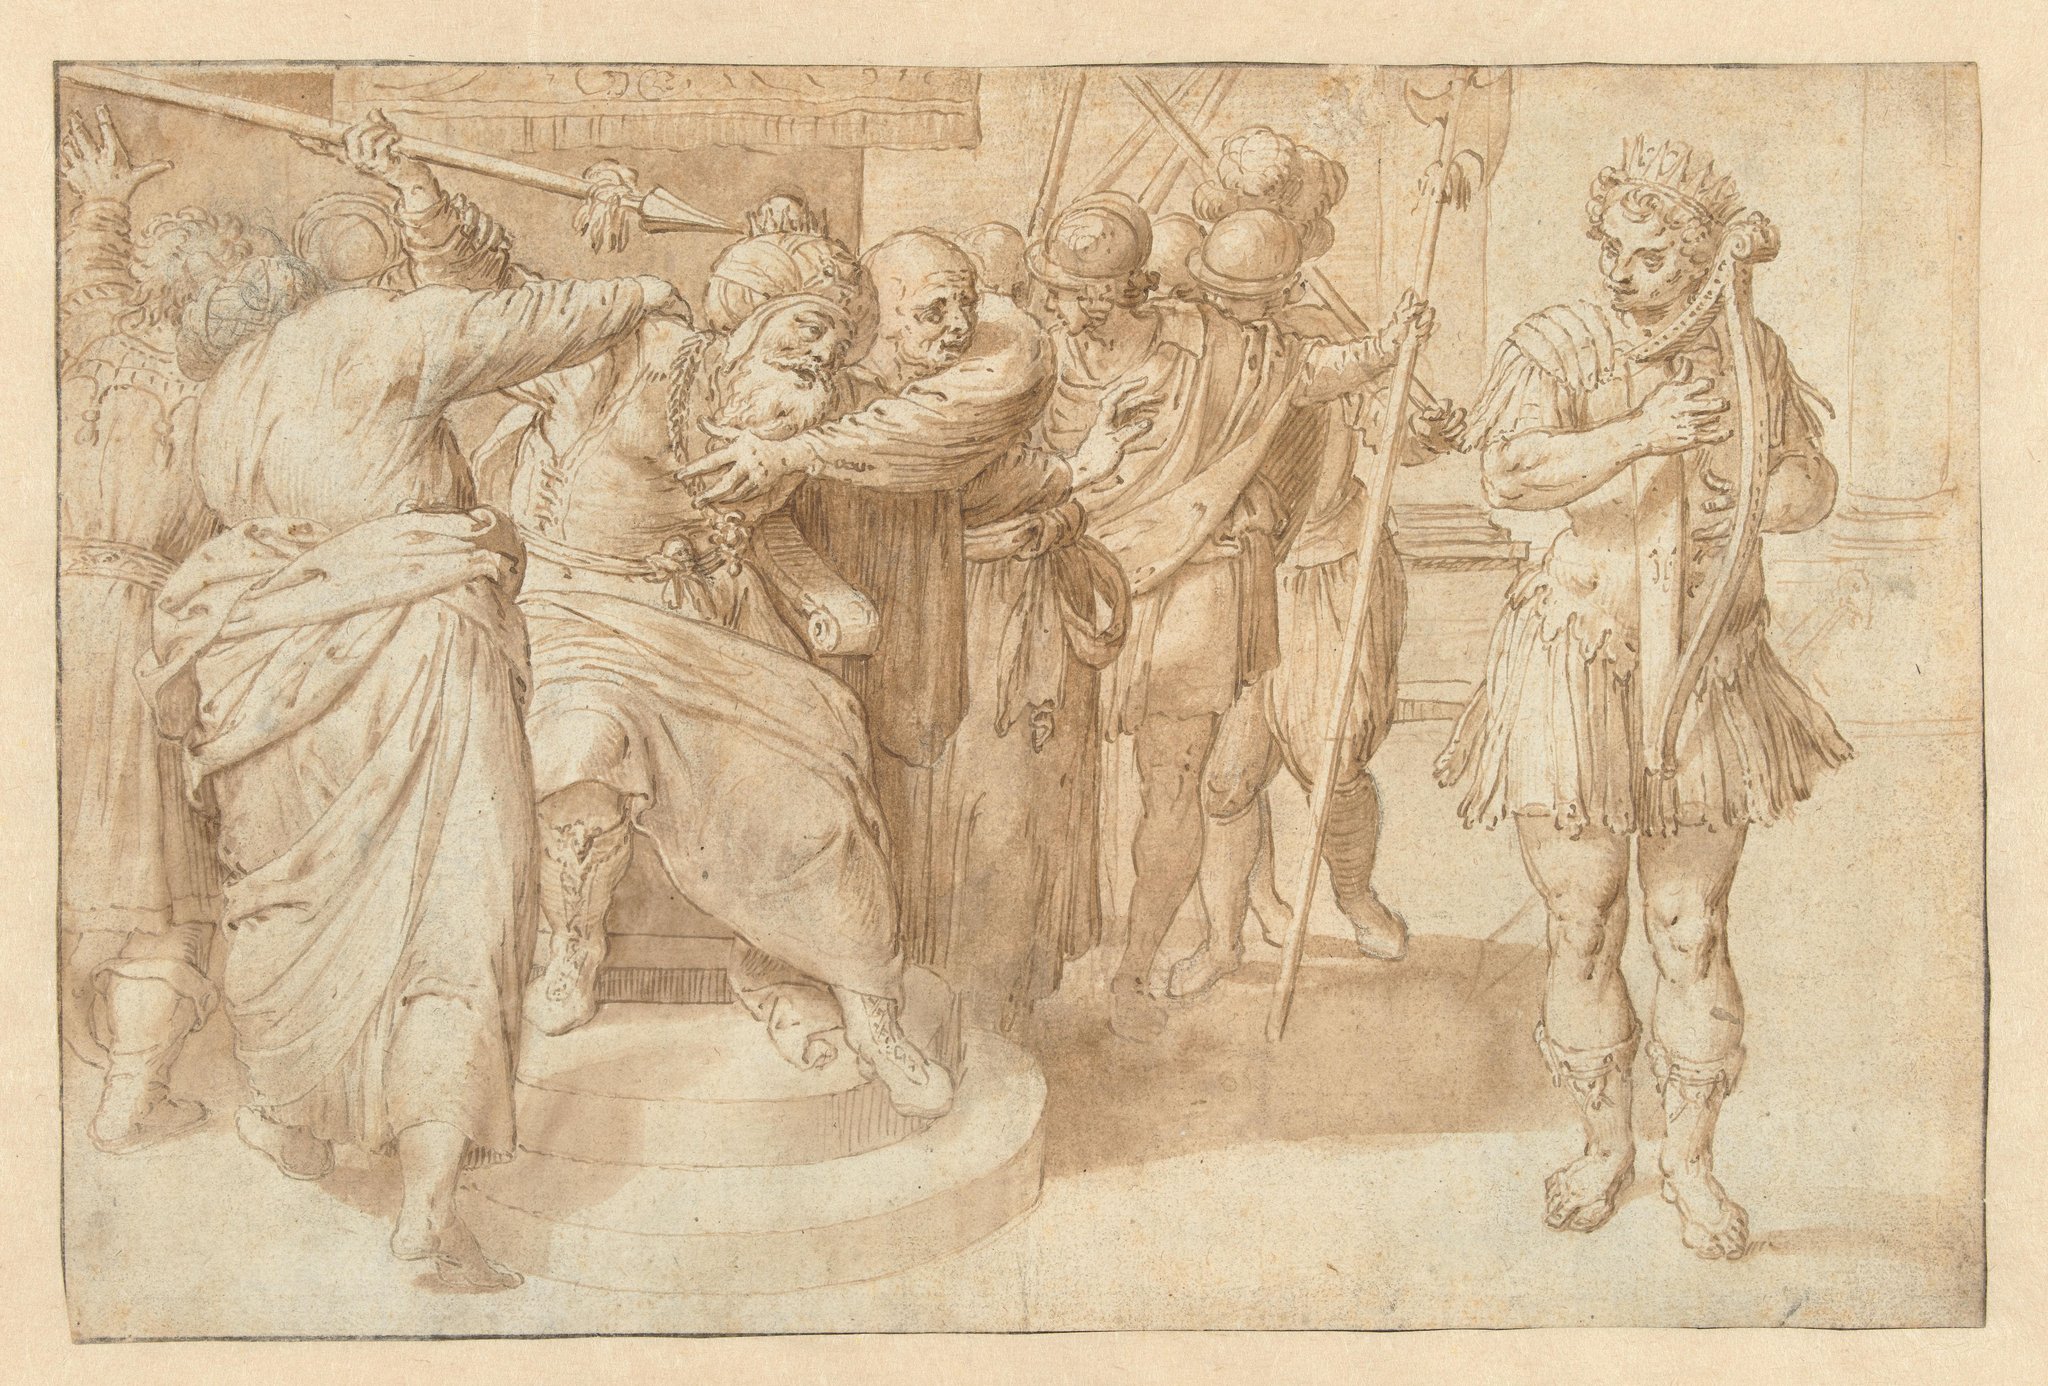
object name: drawing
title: David harpspelend voor Saul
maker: ambrosius francken (i)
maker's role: draughtsman, print maker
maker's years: 1544-1618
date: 1554-1618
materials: chalk, ink, paper, pencil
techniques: pouncing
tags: david as harpist at saul's court (1 samuel 16:14-23)